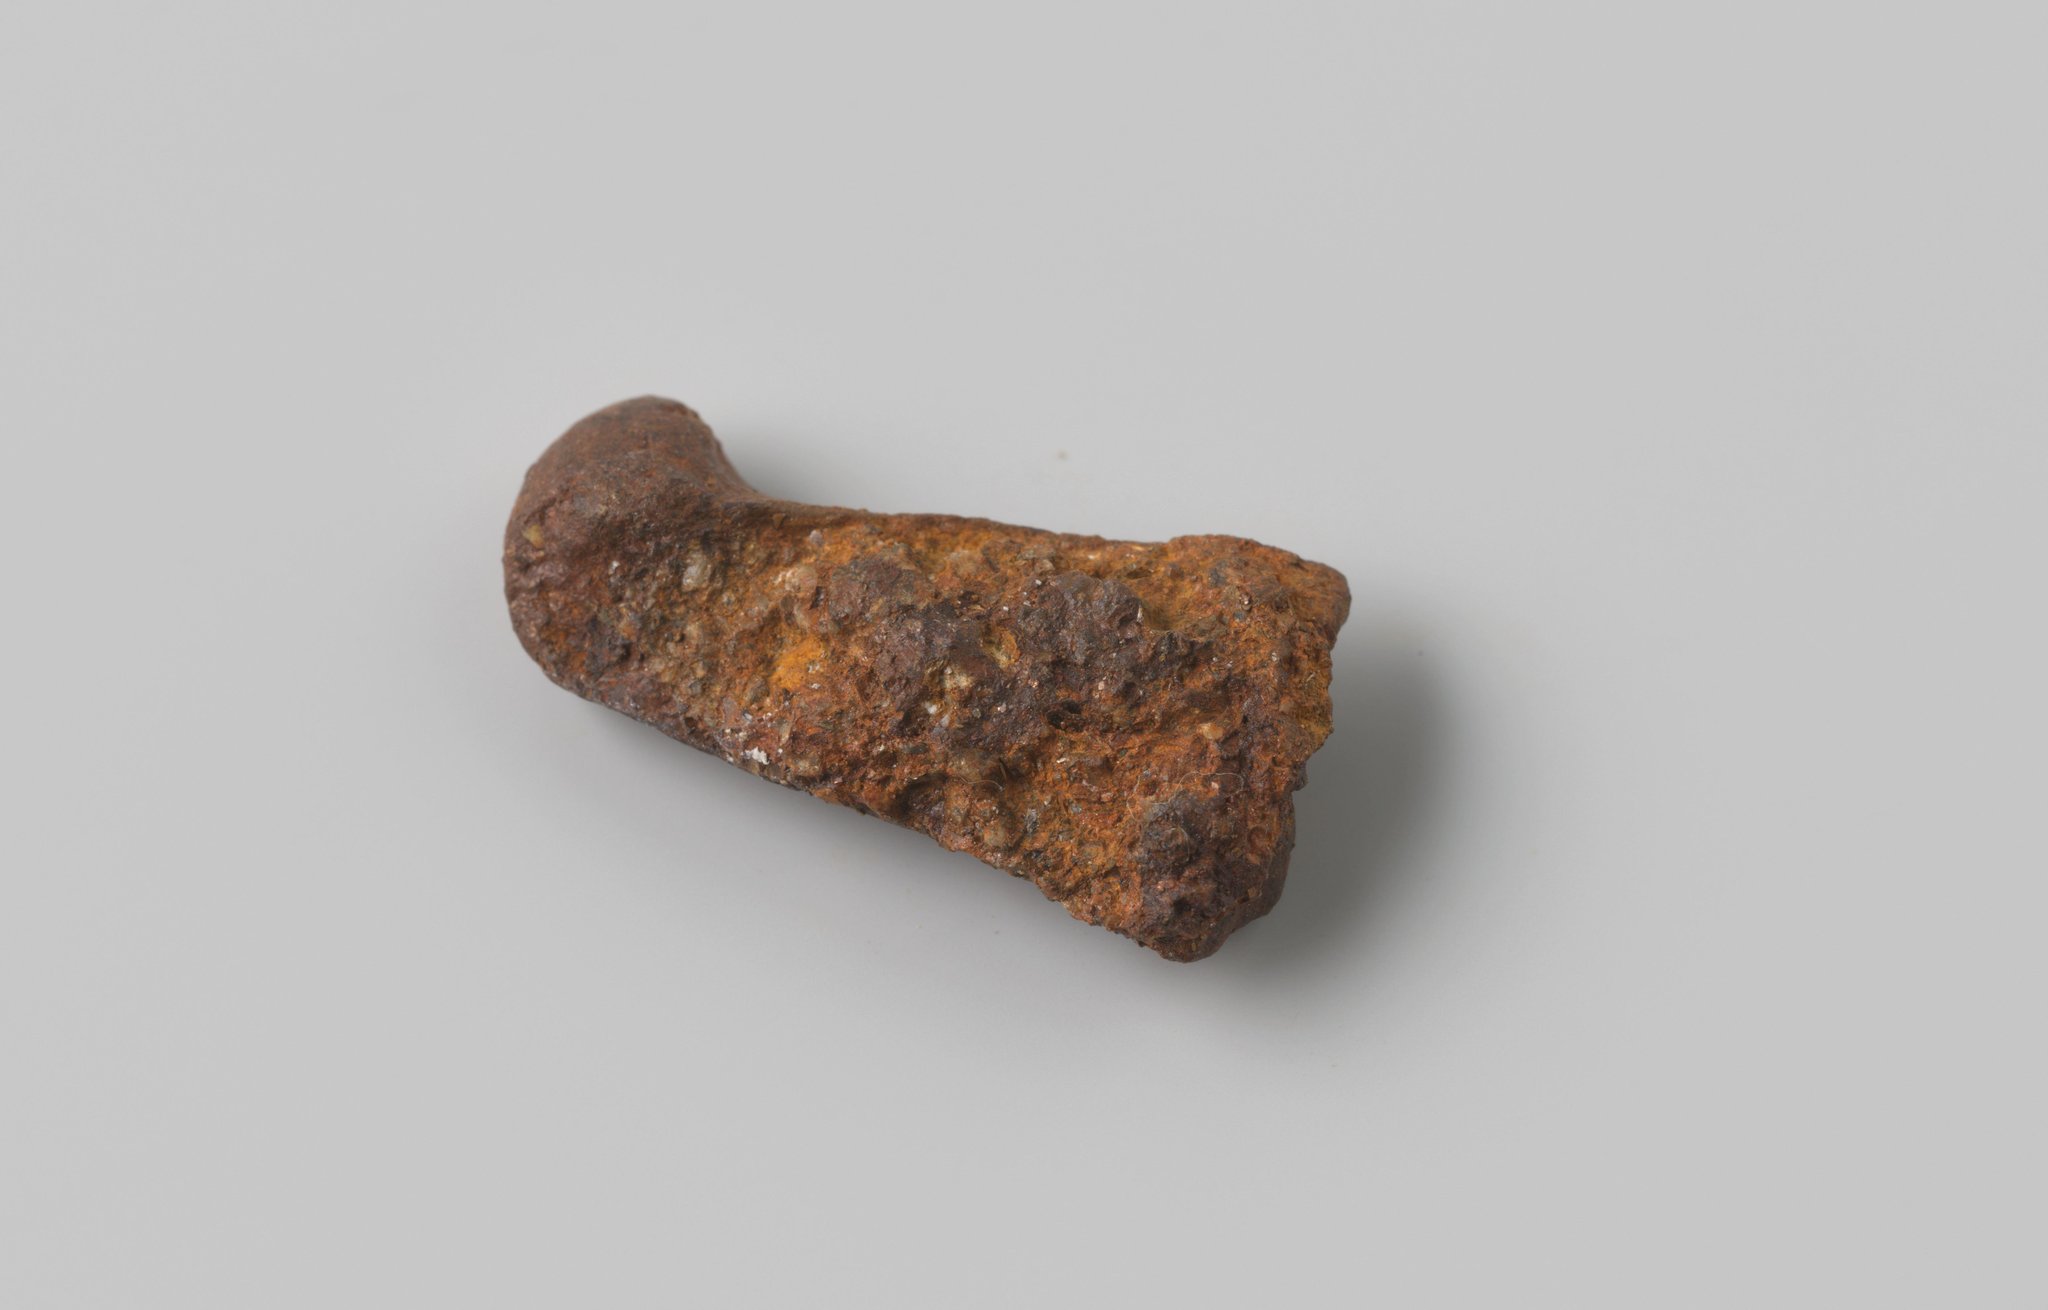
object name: bone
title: Botje van een varkenspoot uit het wrak van de Oost-Indiëvaarder Hollandia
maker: niet van toepassing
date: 1700-1743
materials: bone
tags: verenigde oostindische compagnie, hollandia (schip), annet